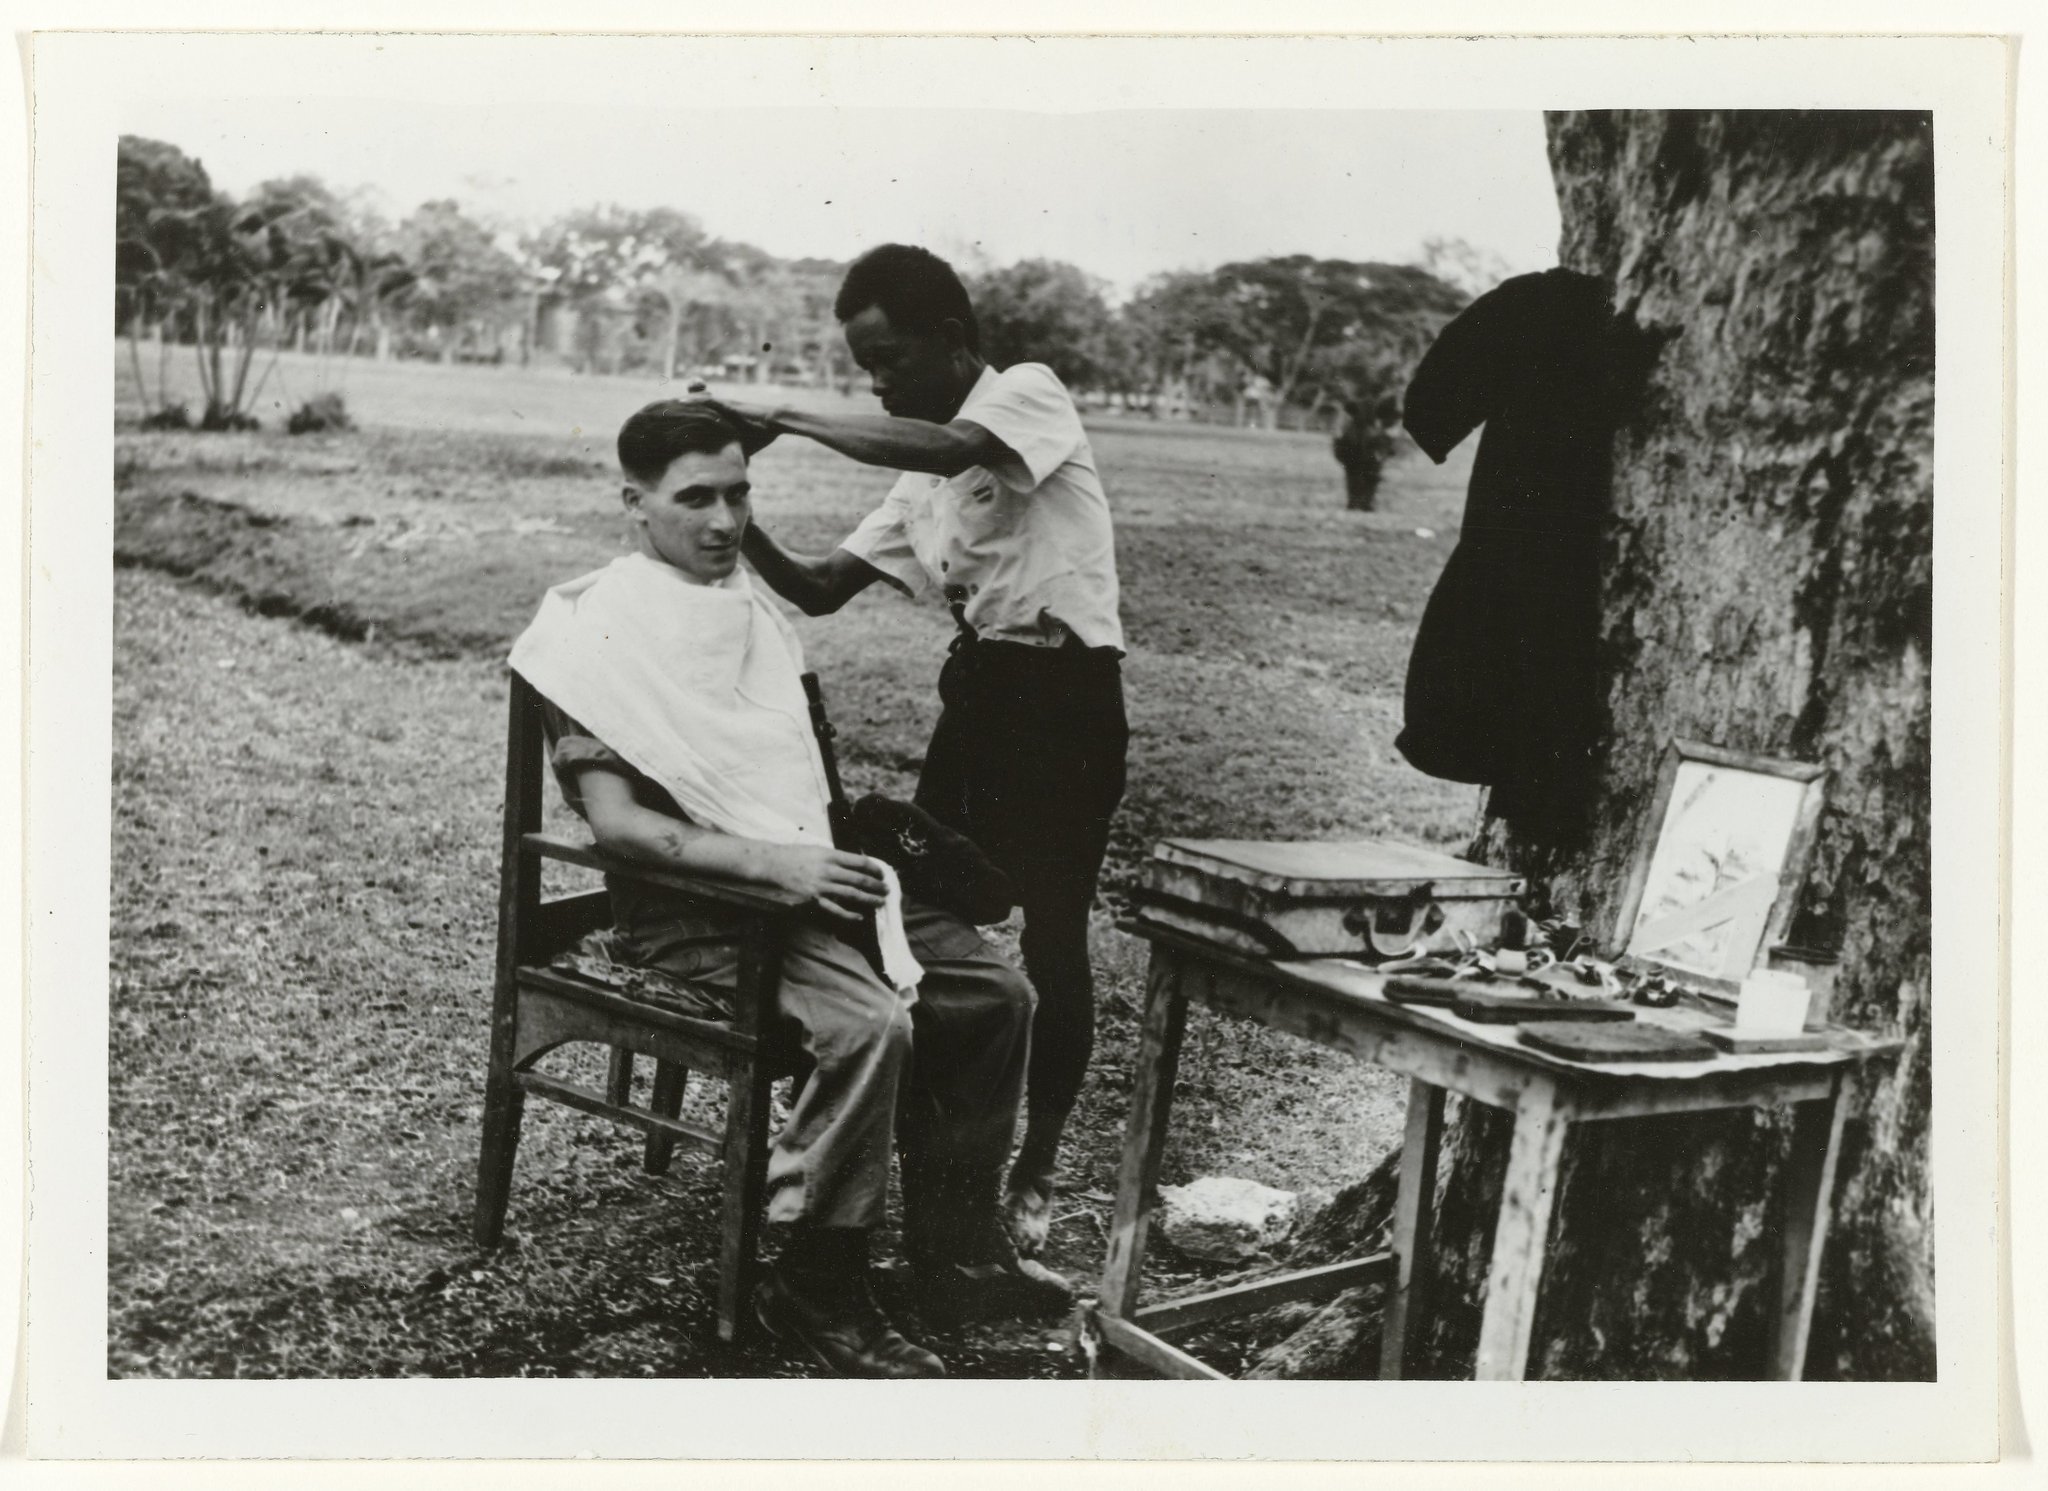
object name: photograph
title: Kapper in Batavia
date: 1945-1946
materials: photographic support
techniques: photography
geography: indonesia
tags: batavia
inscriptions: inscription, stamp: ‘COPYRIGHT / 'ANEFO' / ALGEMEEN NEDERLANDSCH FOTOBUREAU’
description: Geallieerde soldaat bij een kapper in Batavia. De kapper verricht zijn werk in de open lucht.